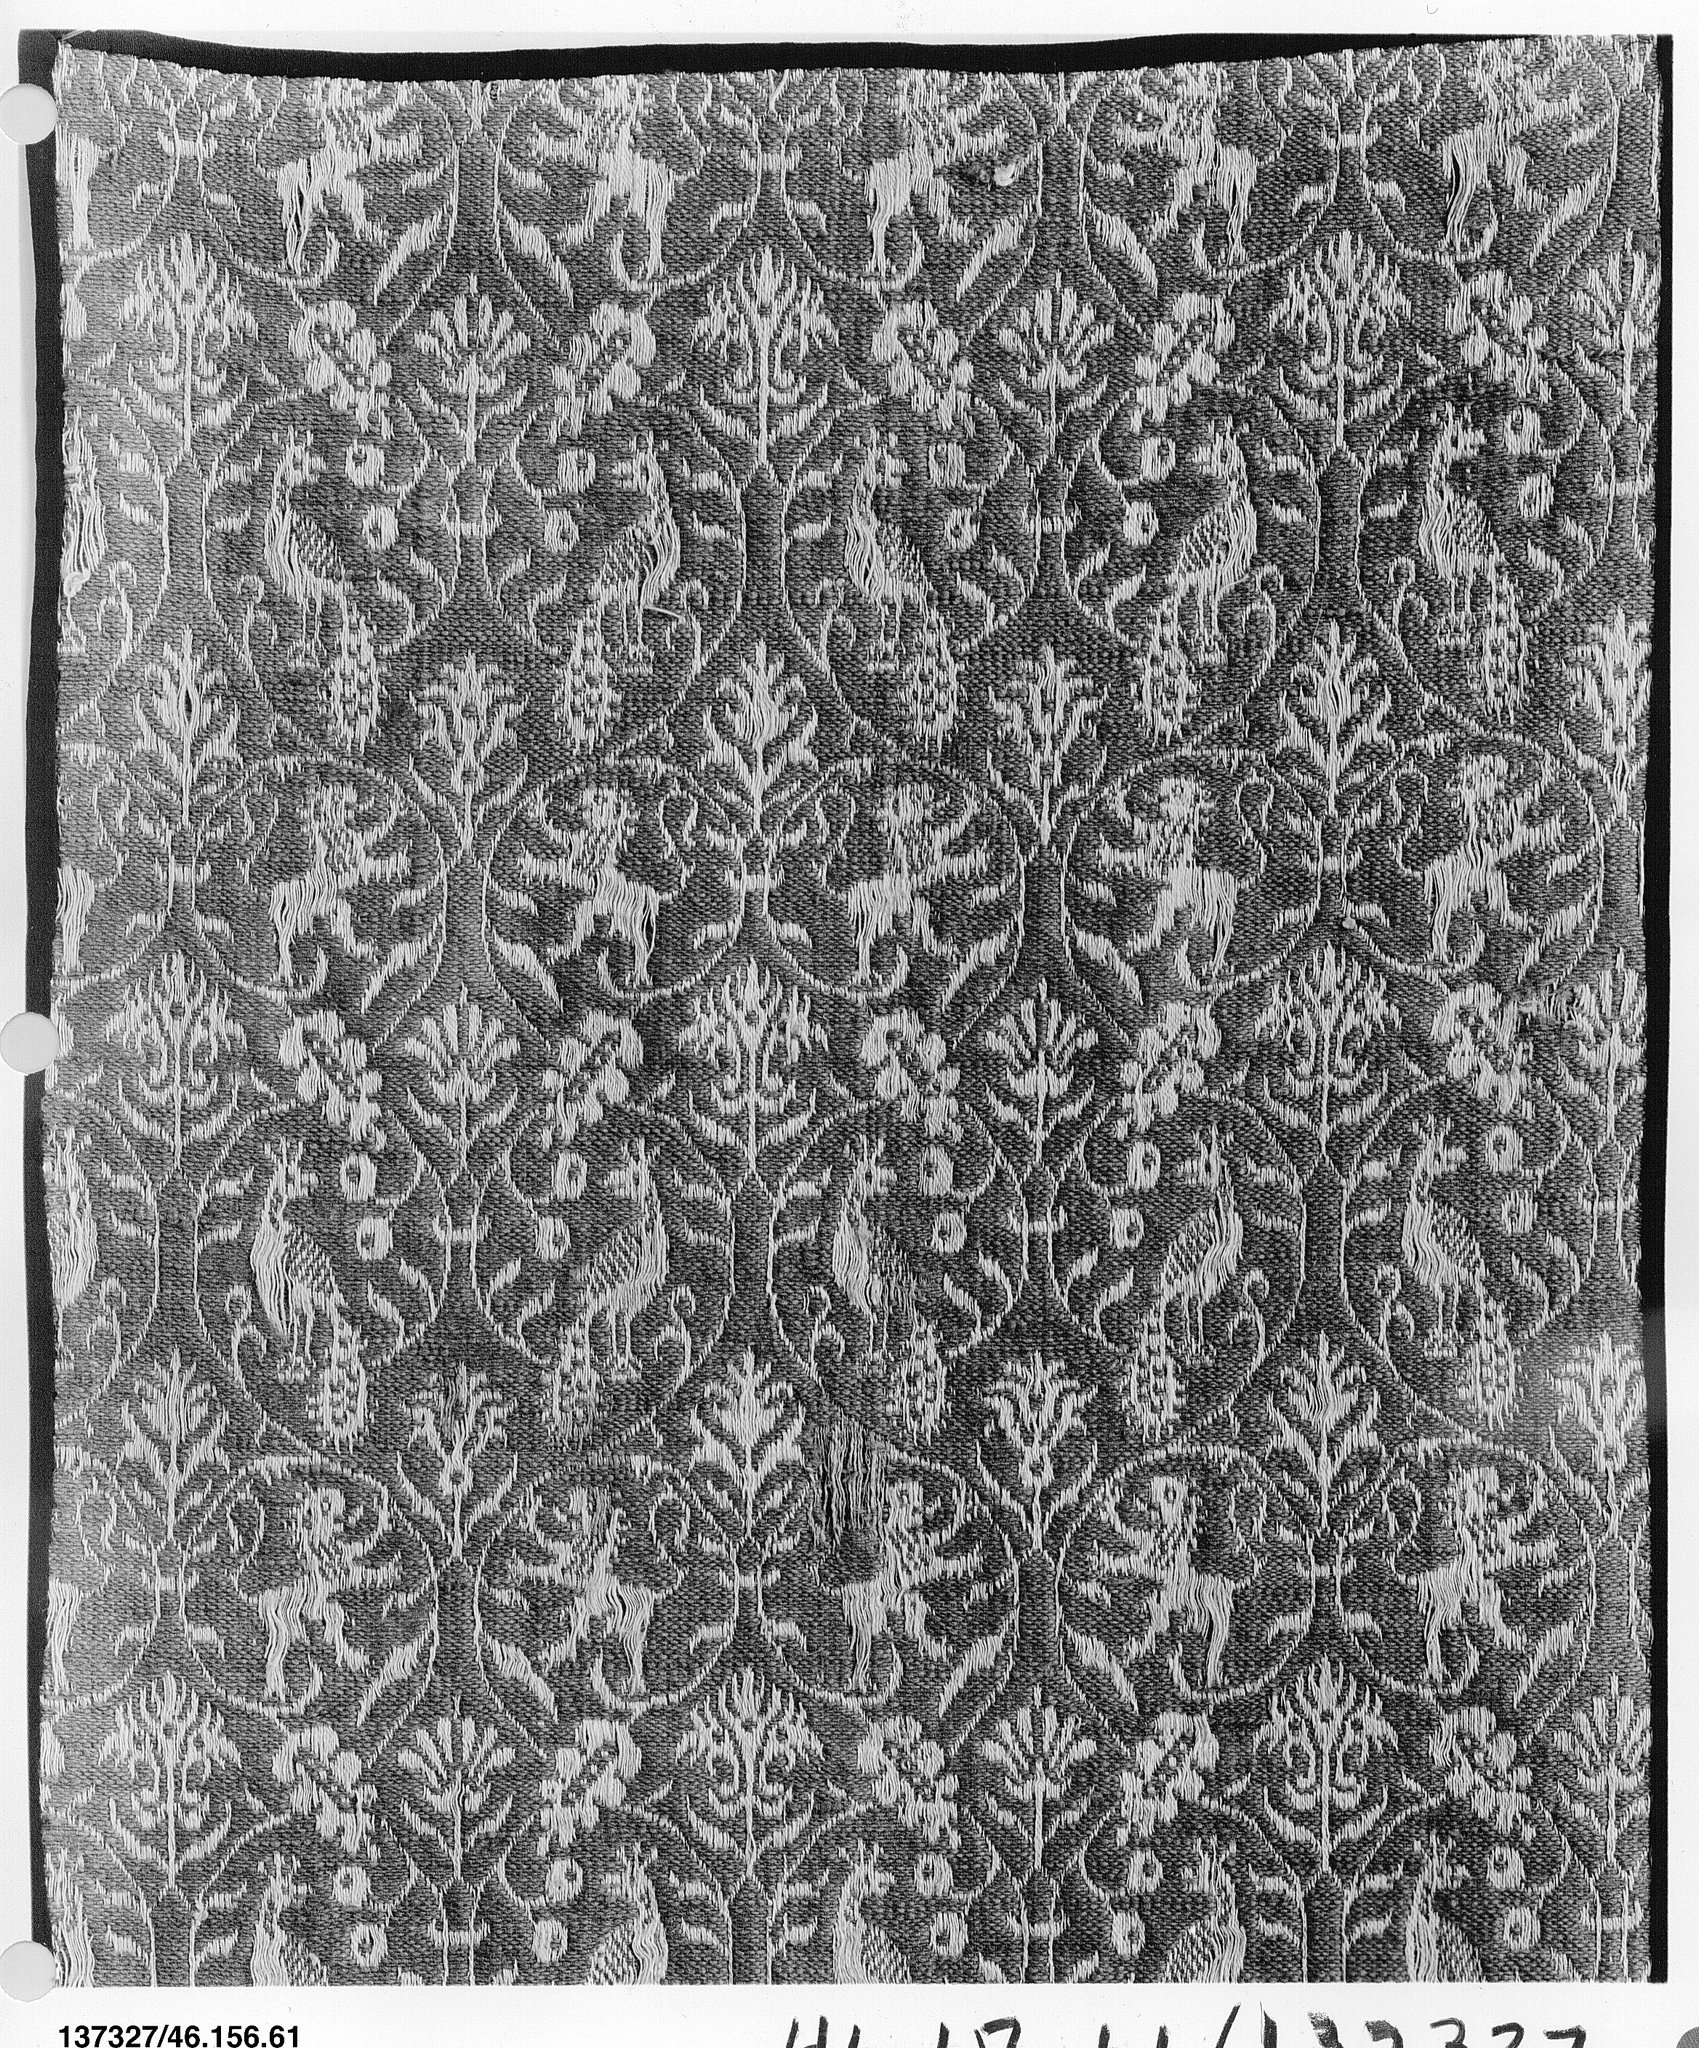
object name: piece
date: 1501-1600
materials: linen, wool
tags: peacocks,lions